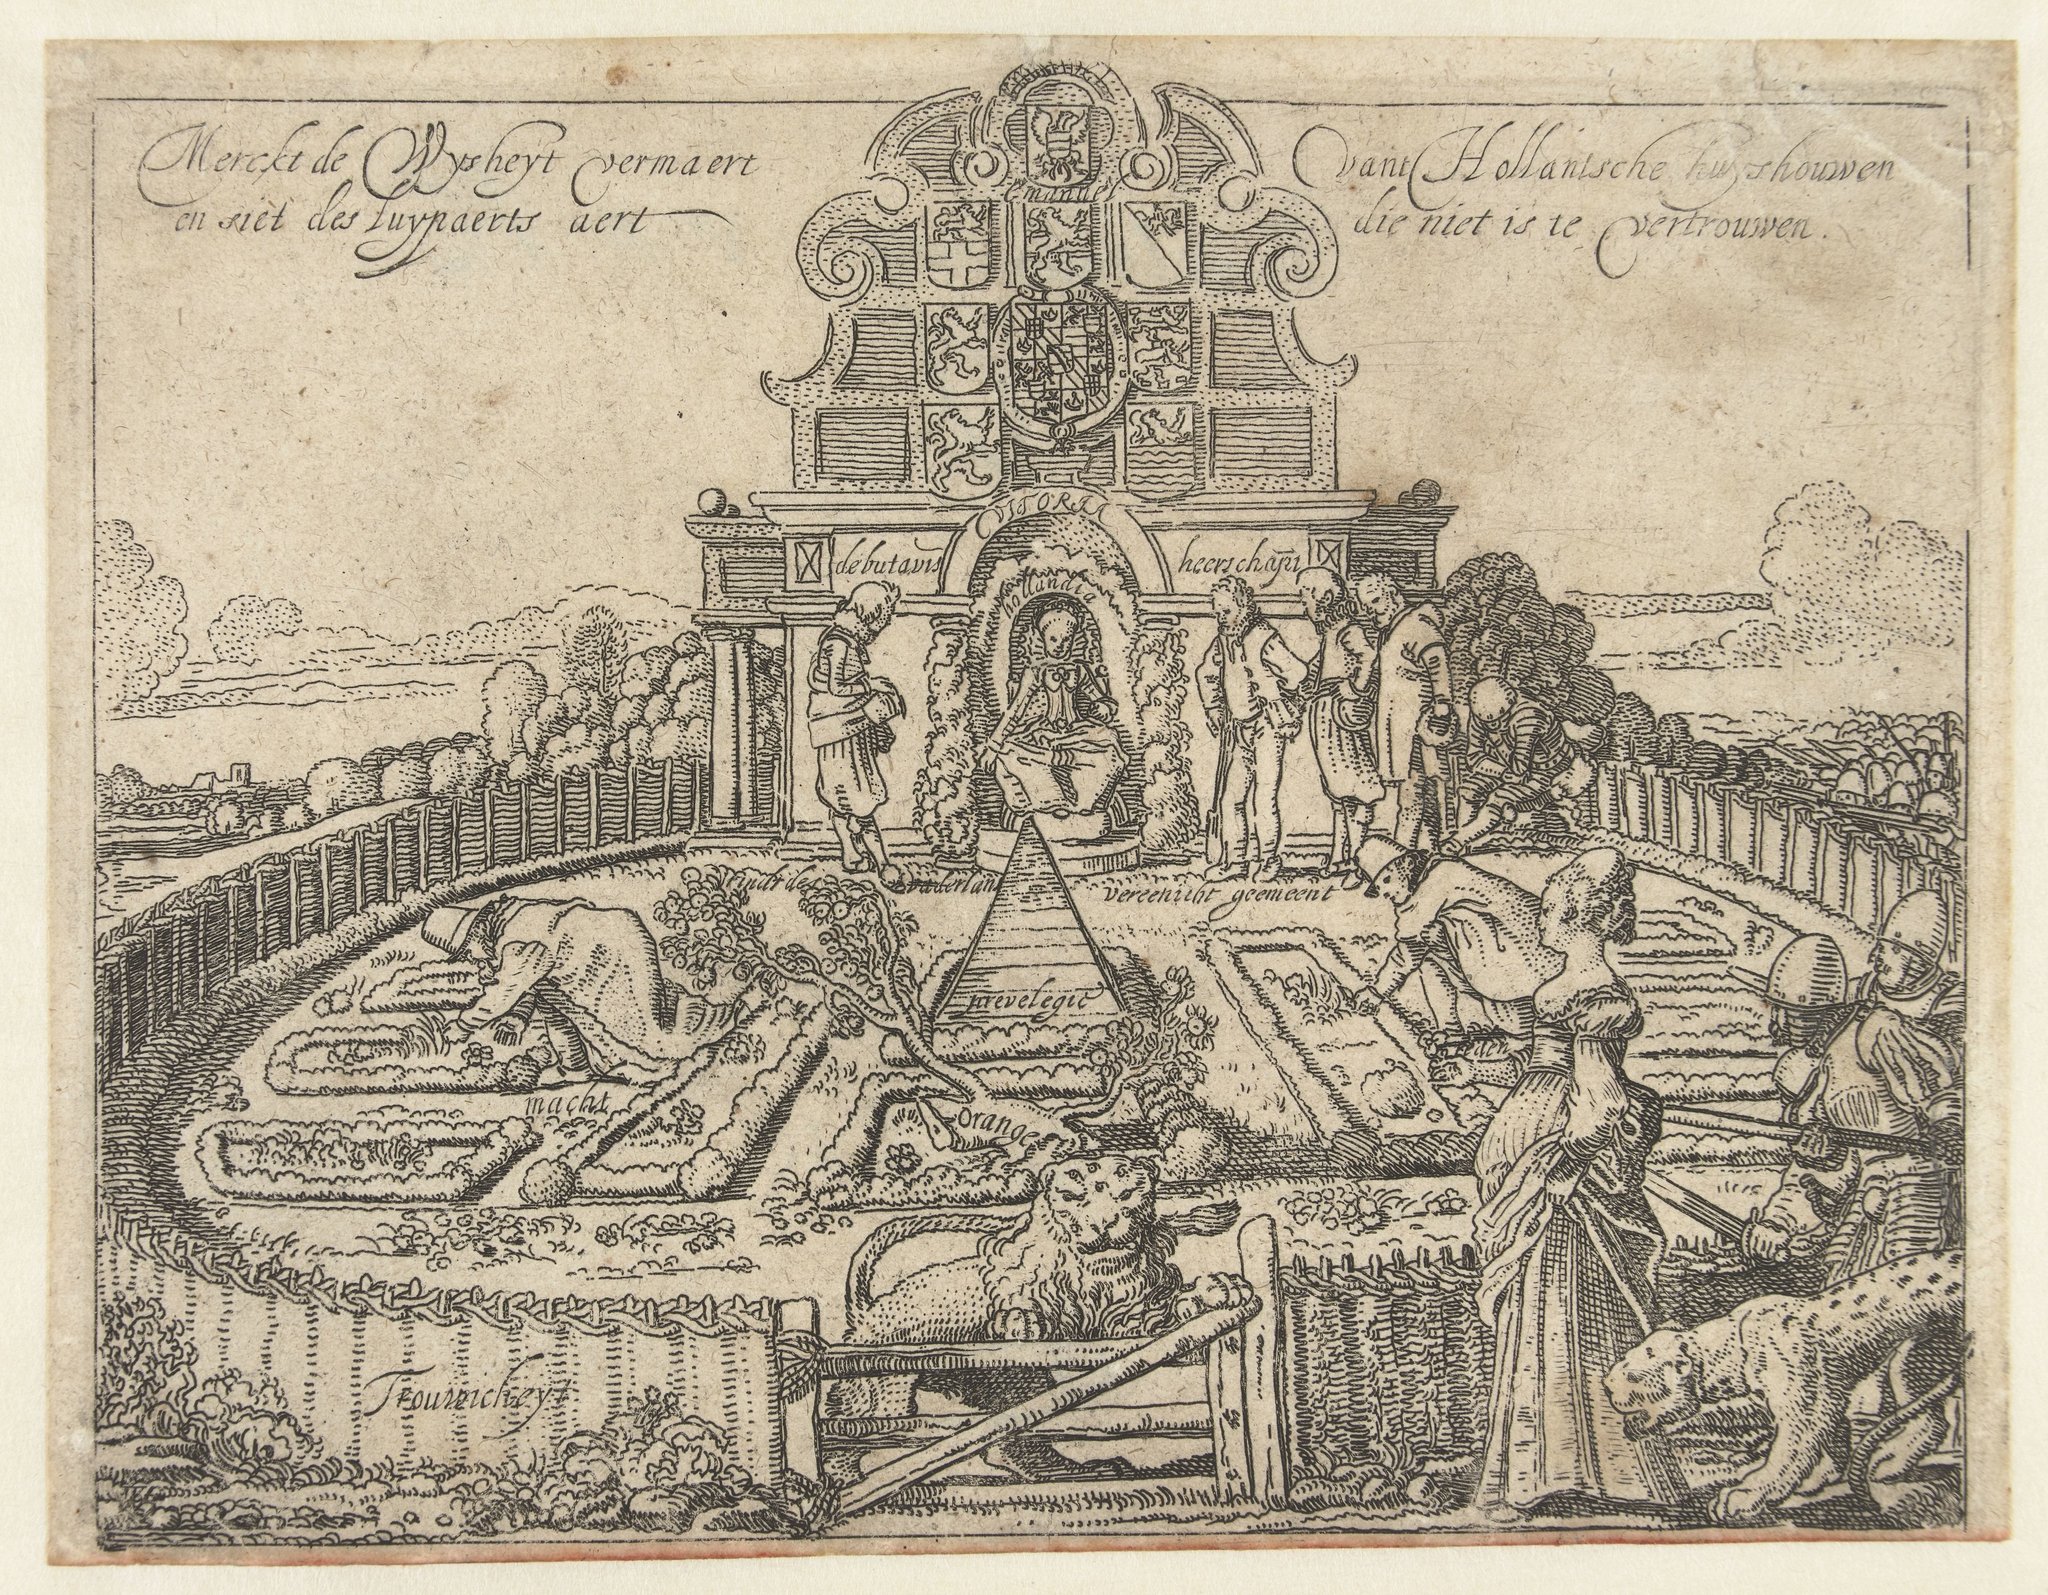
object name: print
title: Allegorie op de onbetrouwbaarheid van Spanje en de vrijheid en welstand van de Zeven Provinciën: de Hollandse Tuin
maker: willem pietersz buytewech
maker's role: draughtsman, print maker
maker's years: 1592-1624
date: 1615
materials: paper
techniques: etching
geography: netherlands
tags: tachtigjarige oorlog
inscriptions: collector's mark: Lugt 2228a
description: Allegorie op de onbetrouwbaarheid van Spanje en de vrijheid en welstand van de Zeven Provinciën voorgesteld met de Hollandse Tuin. Prent gebruikt voor het pamflet Merckt de Weijsheyt vermaert vant Hollantsche huyshouwen en siet des luypaerts aert die niet is te vertrouwen